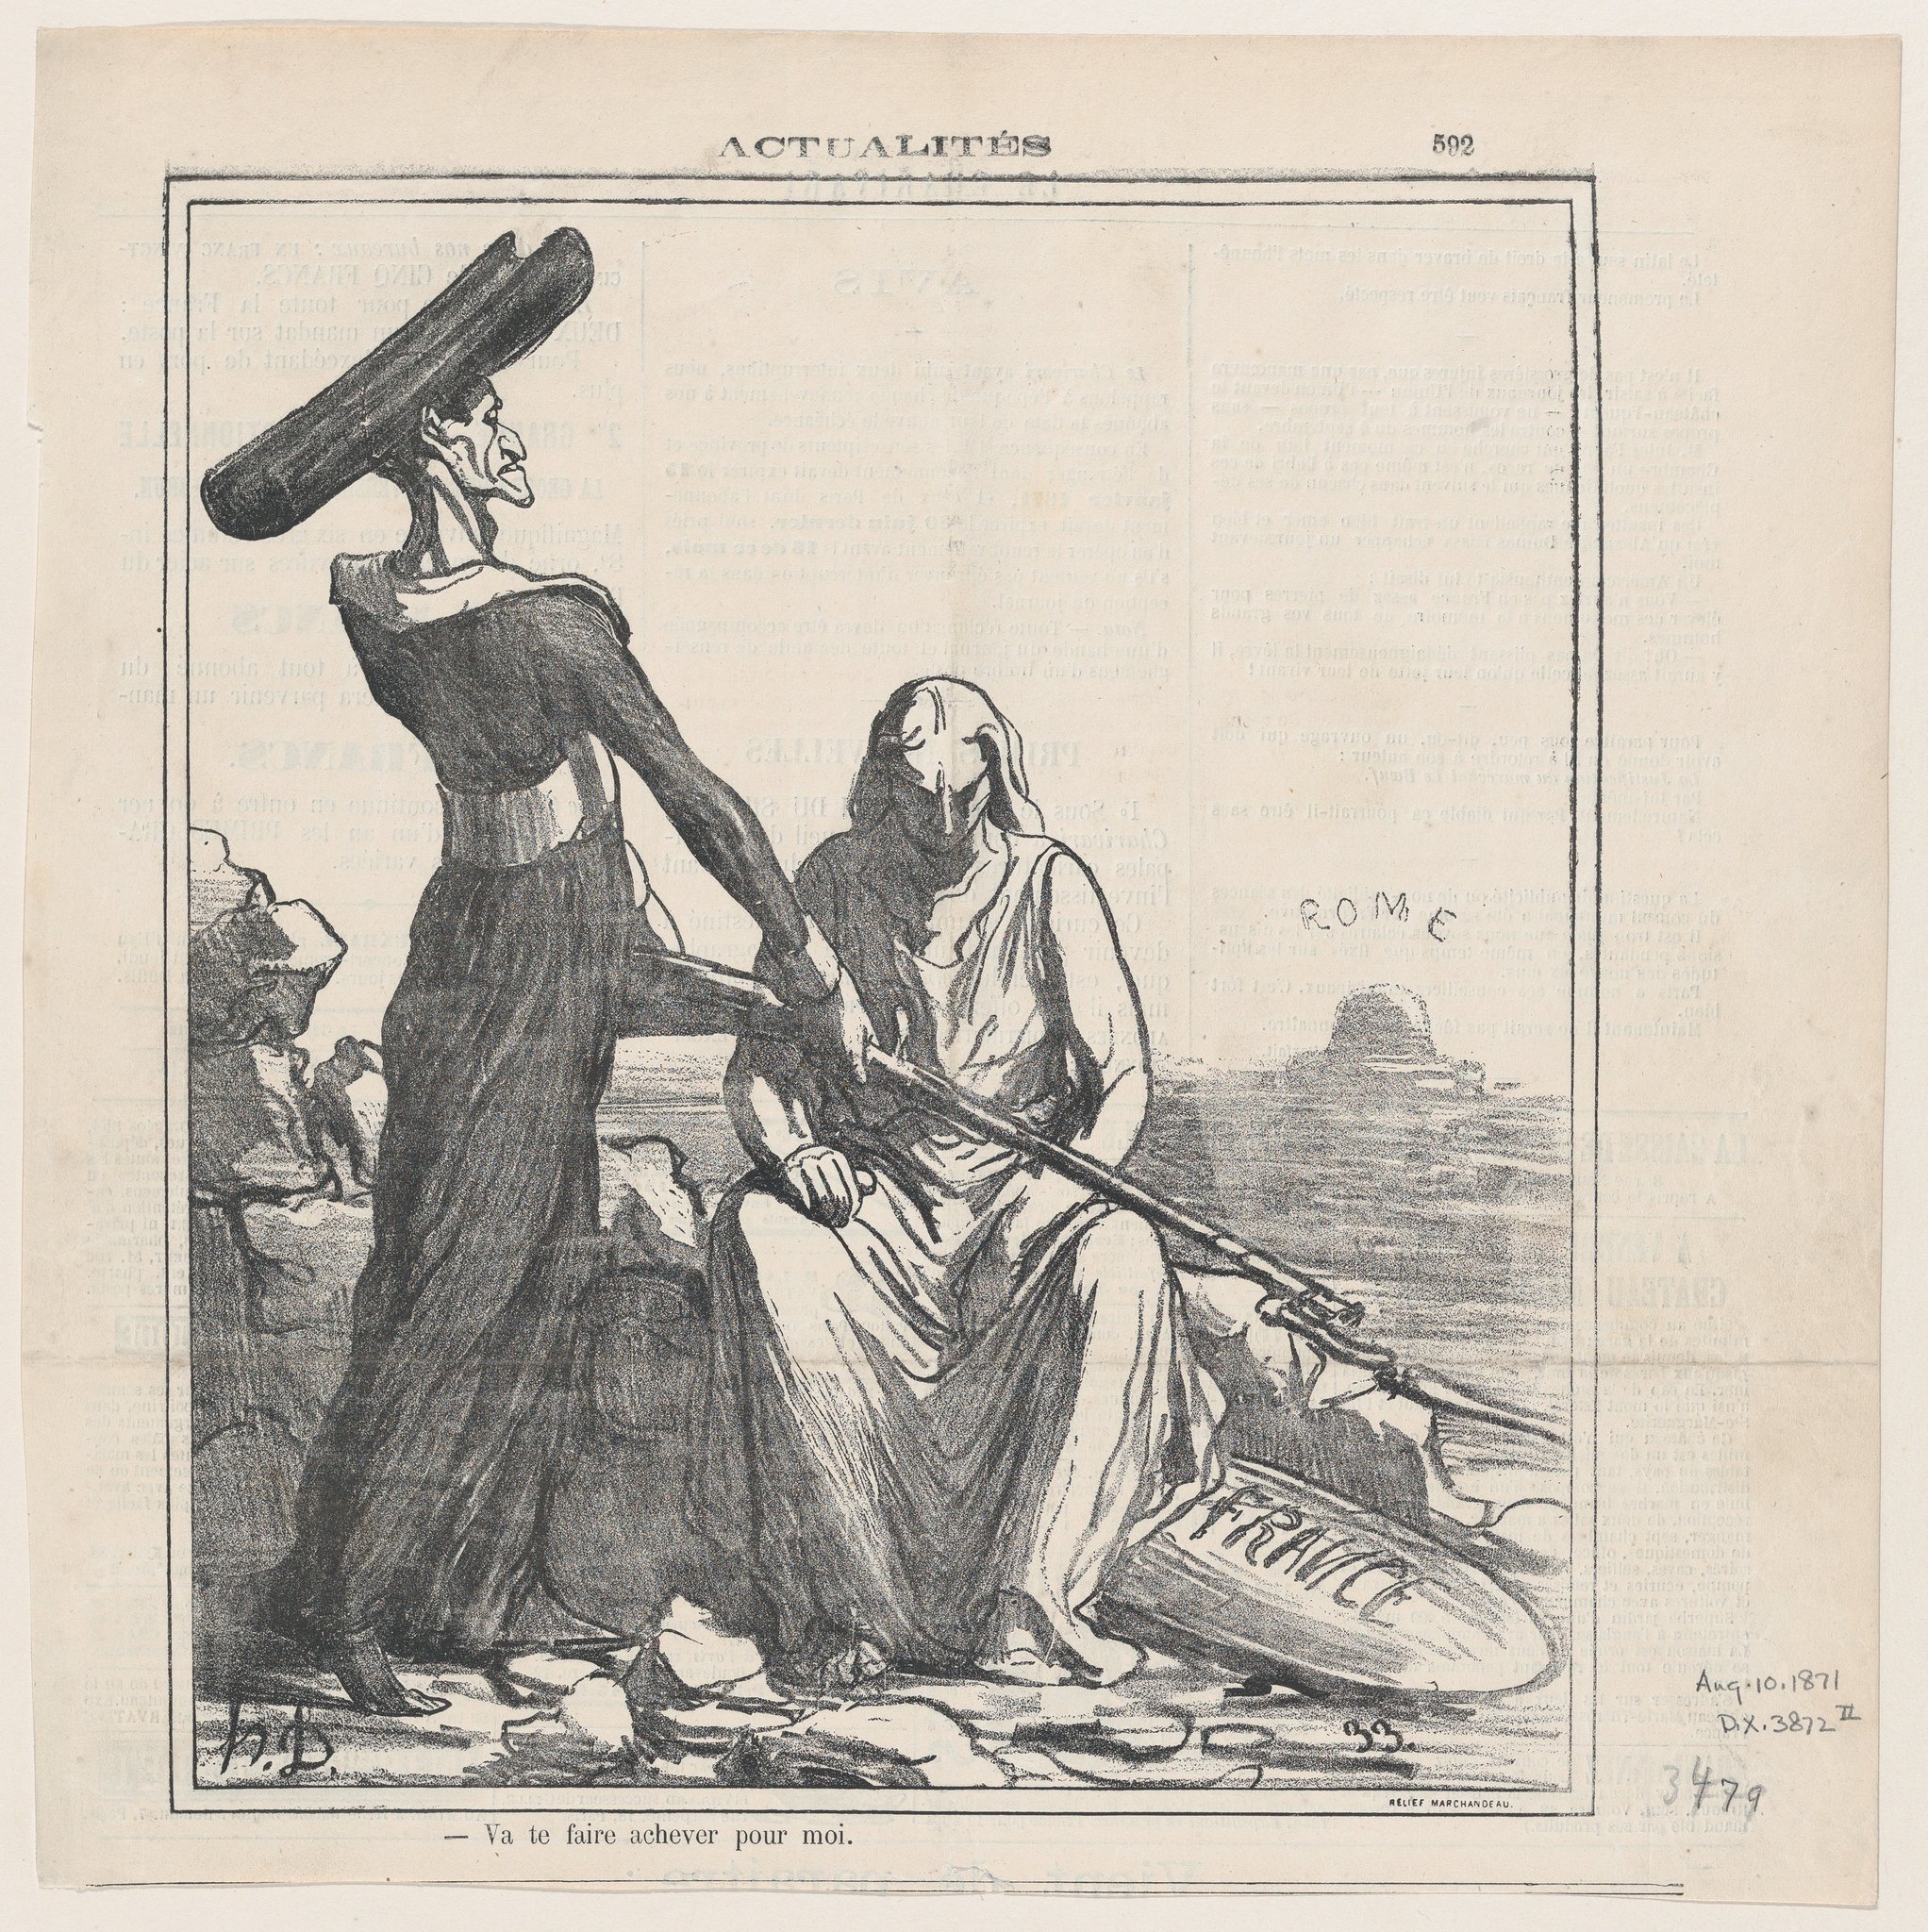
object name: print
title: Go and get yourself killed for me, from 'News of the day,' published in Le Charivari, August 10, 1871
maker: honoré daumier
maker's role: artist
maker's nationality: french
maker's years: 1808-1879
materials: paper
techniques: lithograph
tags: satire,men,women